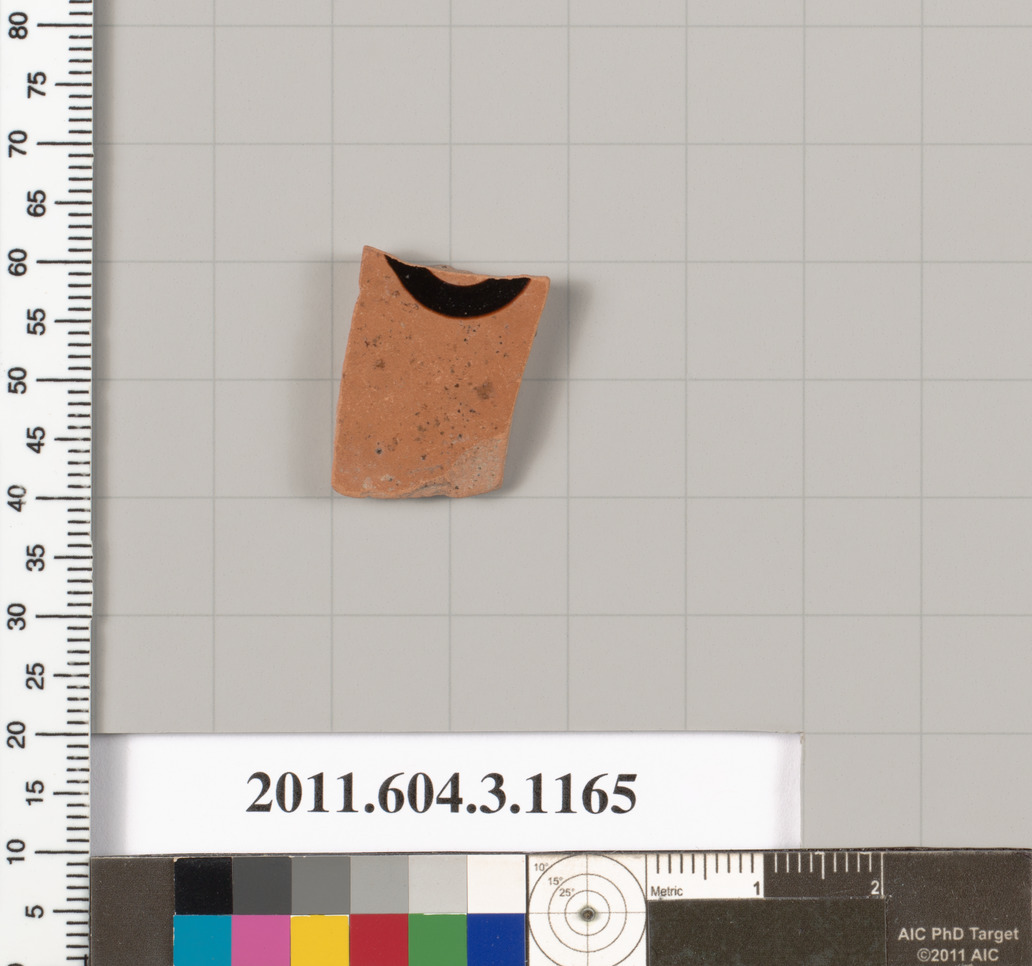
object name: mastoid or kyathos fragment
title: Terracotta fragment of a mastoid (drinking cup with narrow base) or a kyathos (cup-shaped ladle)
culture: greek, attic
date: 534-468 BCE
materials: terracotta